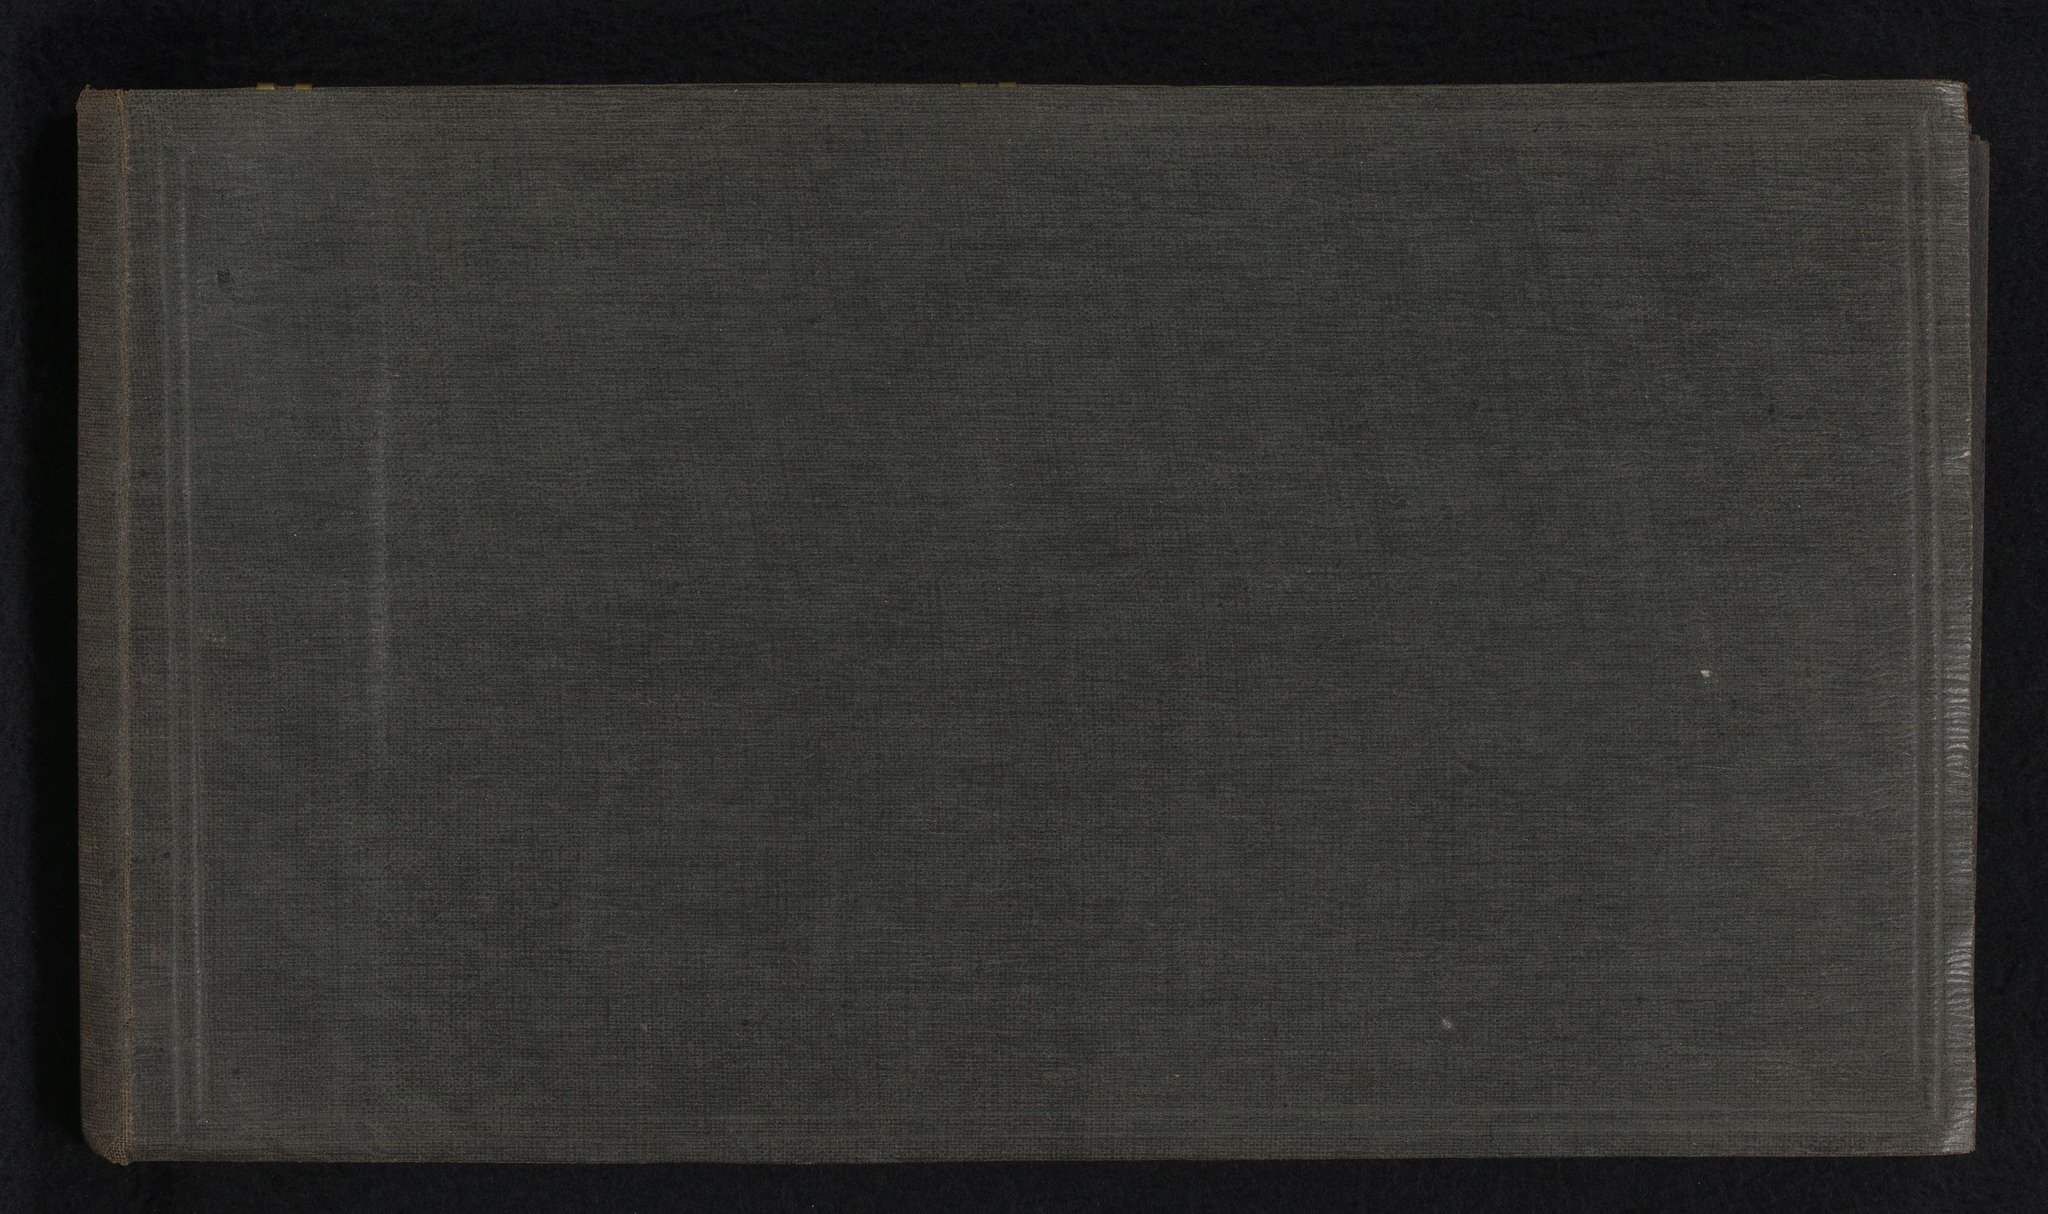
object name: scrapbook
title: Marokko, Algiers, Tunis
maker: a.g.a. van eelde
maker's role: engineer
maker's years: 1862-1950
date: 1927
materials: cardboard, paper, photographic support, textile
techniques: gelatin silver print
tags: historical persons, landscape with ruins, temple, shrine ~ islam, mohammedanism, market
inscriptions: label: ‘Kodak Ltd., London./ "Georgia" Album/ H’, annotation: ‘IM 6 365’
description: Album met 46 pagina's met 39 opgeplakte foto's van de reis door Marokko, Algerije en Tunesië door A.G.A. van Eelde in Maart en April 1927. Het album is samengesteld door Van Eelde en aangeboden aan Bierens de Haan. Achterin zitten twee bladen waarop per foto beschreven staat wat erop te zien is. Het album bevat twee foto's van de reizigers.